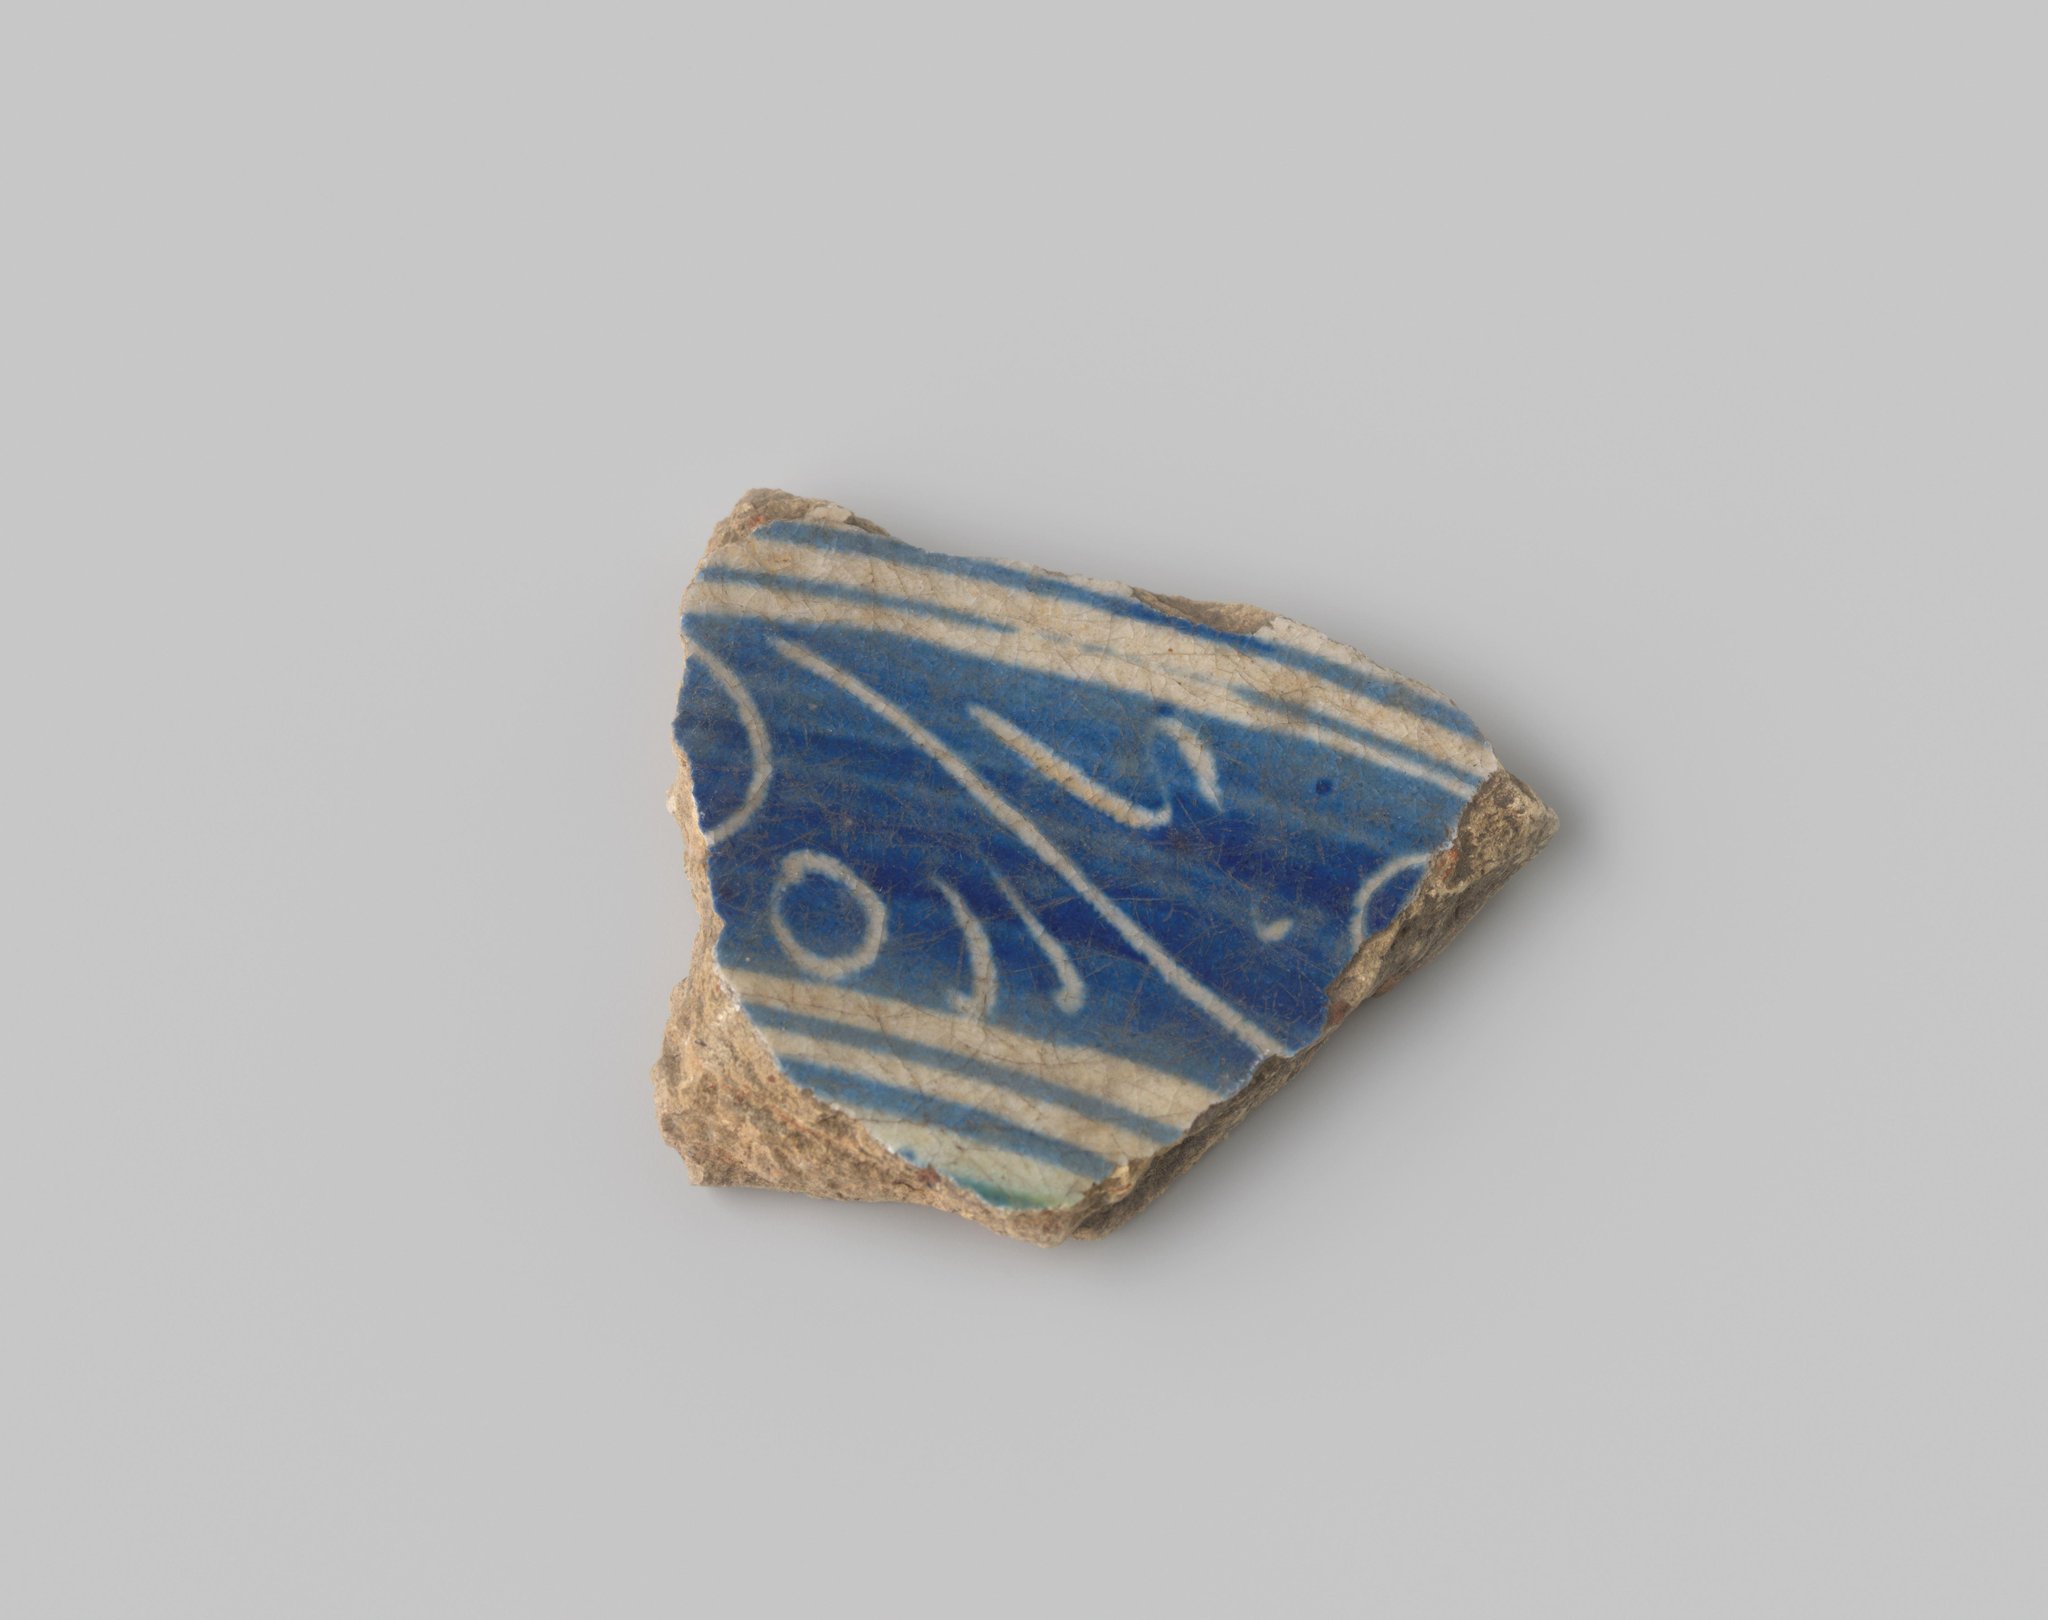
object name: sherd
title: Scherf majolica met decoratie in blauw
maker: Anonymous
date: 1500-1699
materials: earthenware, glaze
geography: northern netherlands